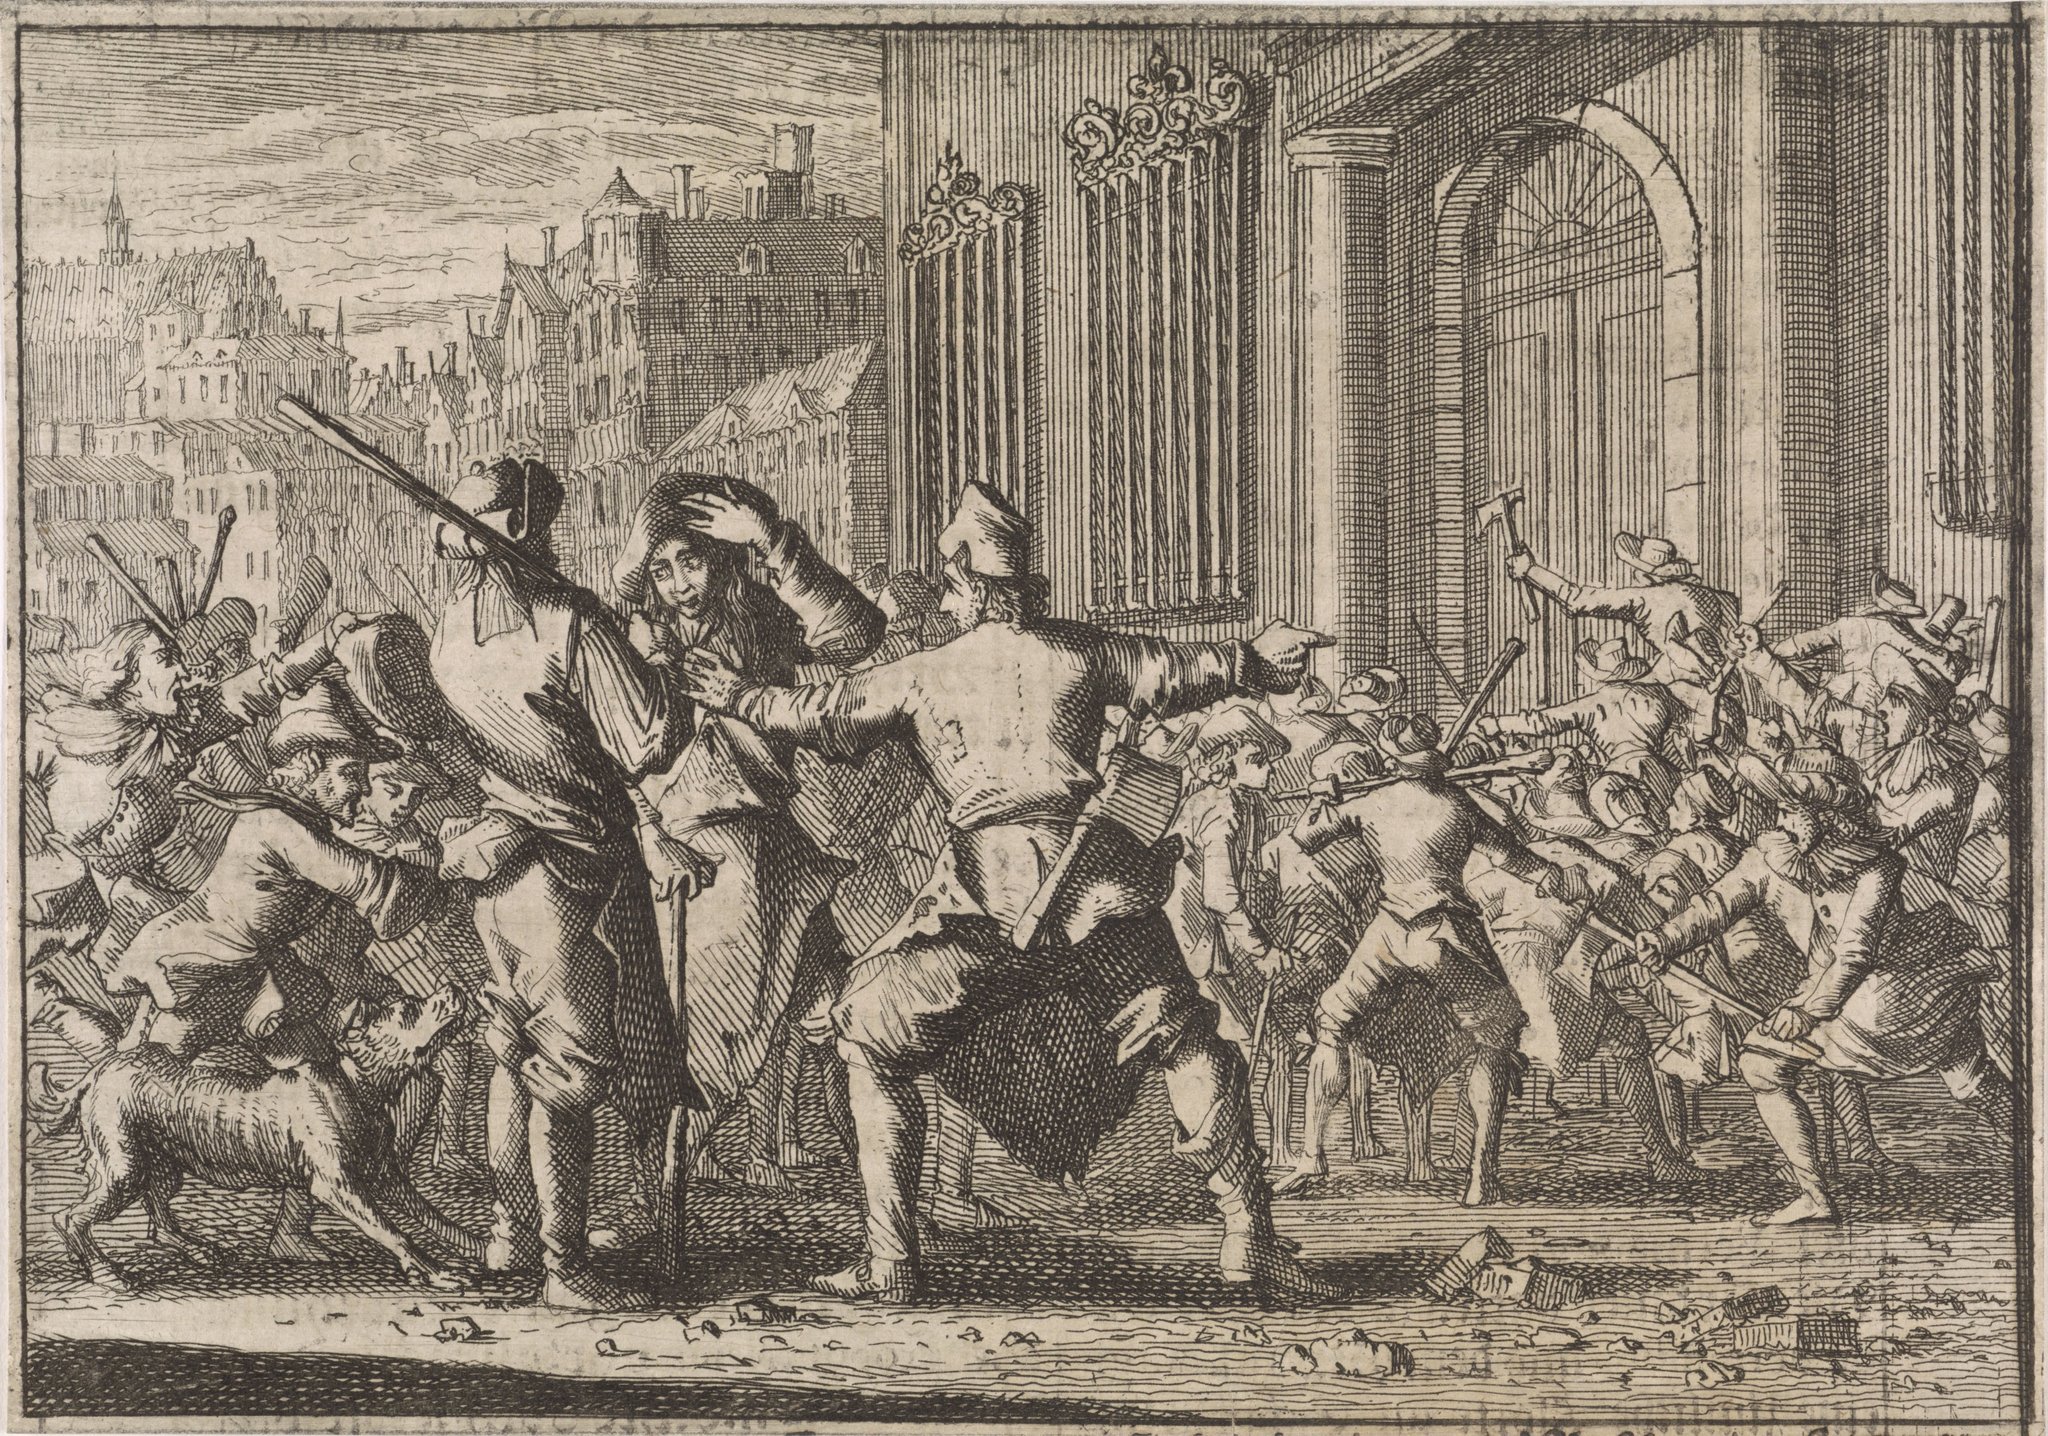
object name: book illustration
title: Opstand in Barcelona, 1640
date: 1701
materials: paper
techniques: etching, letterpress printing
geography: frankfurt am main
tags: revolution, revolt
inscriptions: collector's mark: Lugt 2228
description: Boekillustratie voor Hiob Ludolff. Allgemeine Schau-Bühne der Welt. Deel II. Frankfurt am Main: Johann David Zunnern, 1701, p. 792.